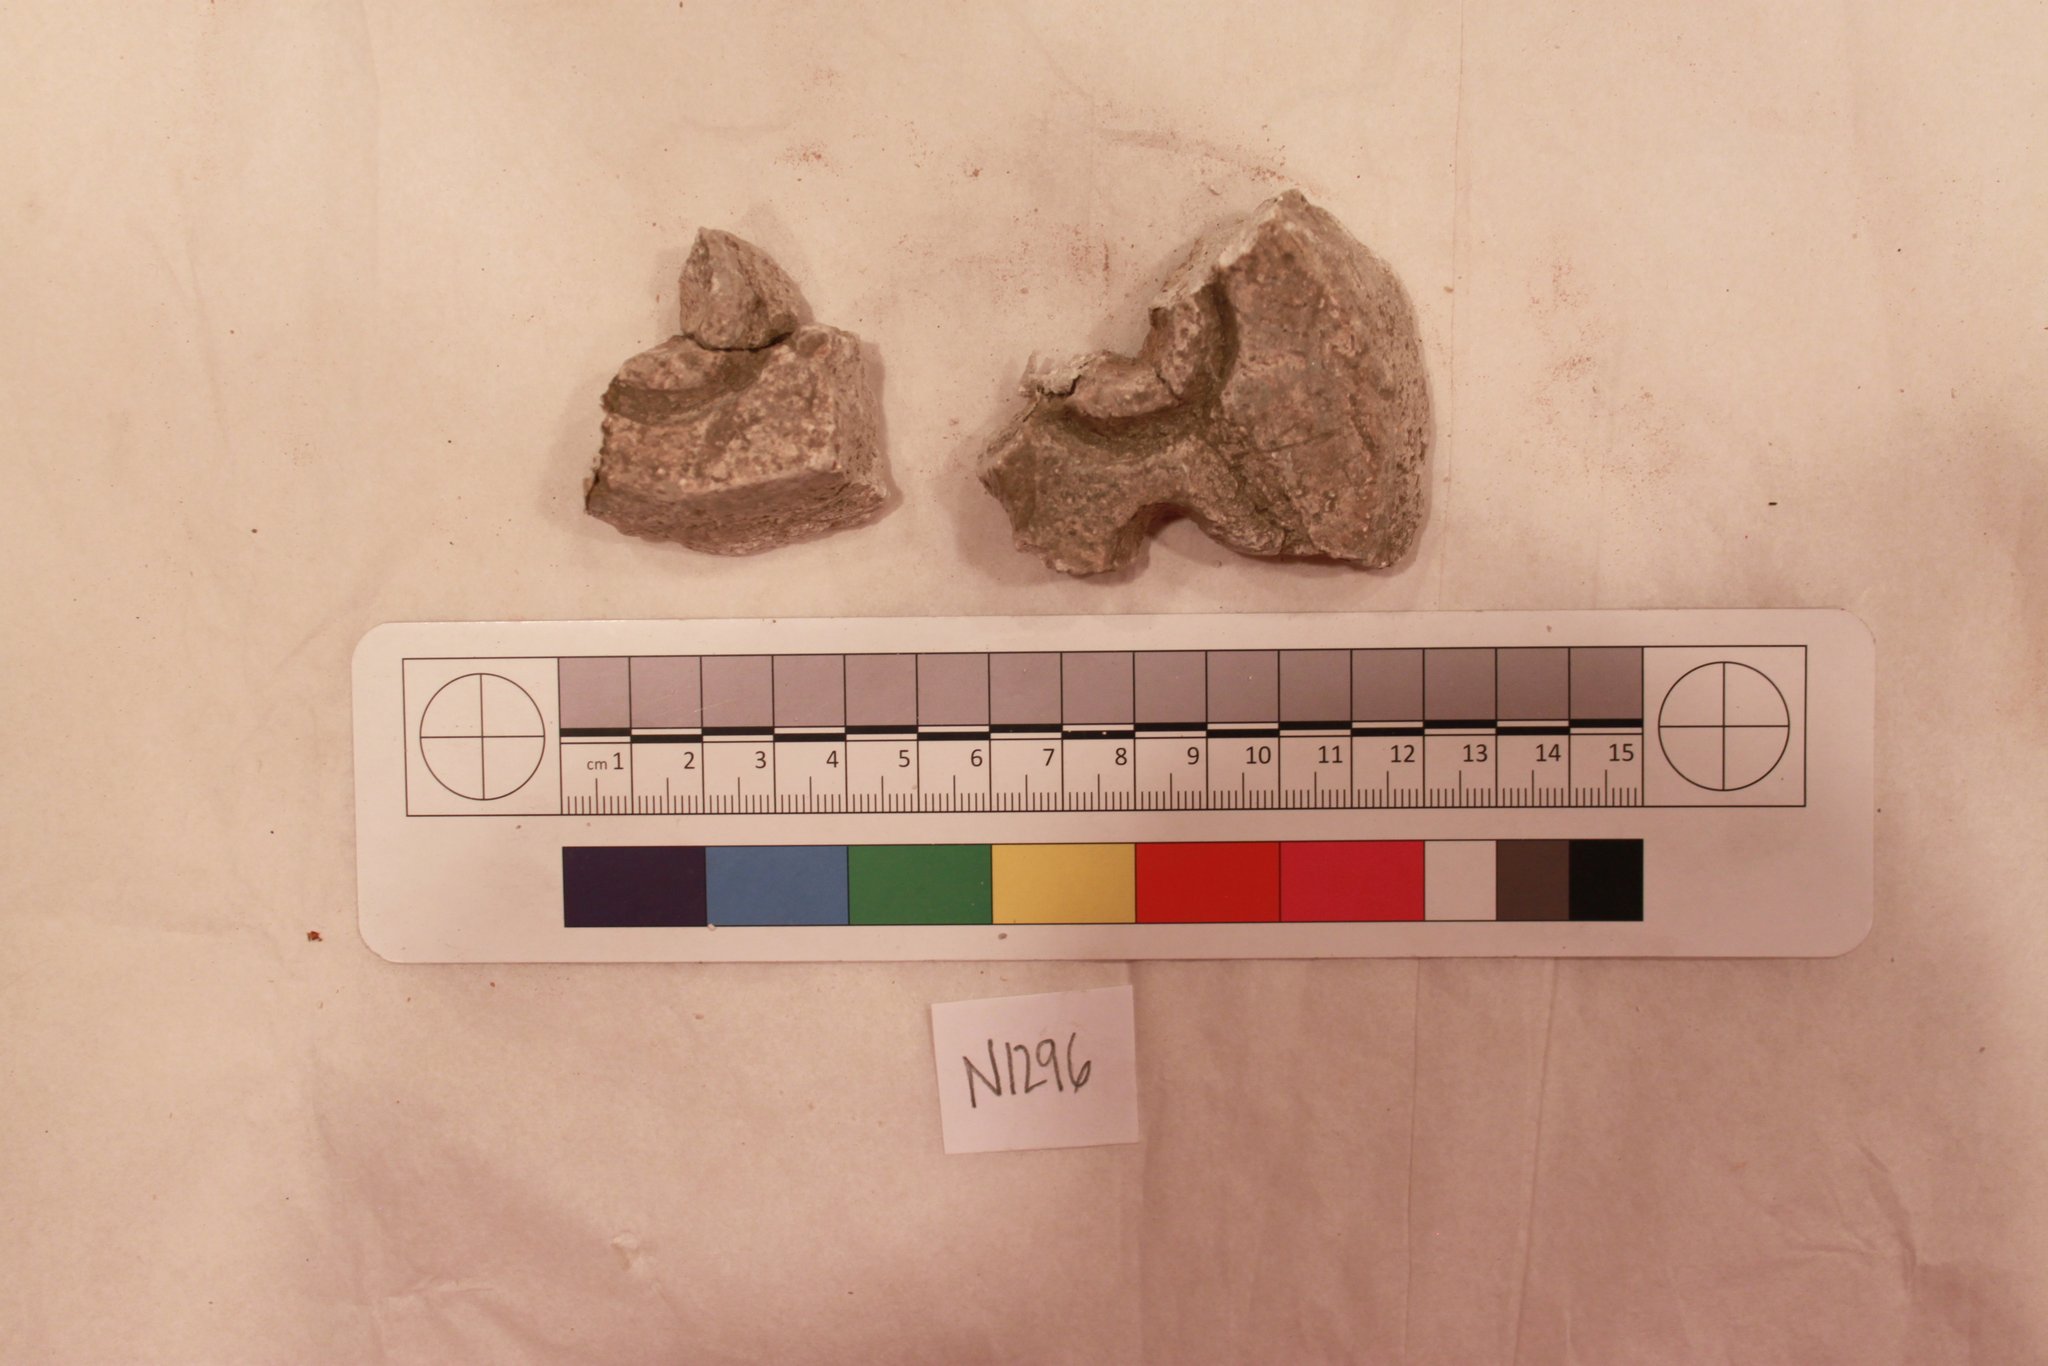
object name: fragment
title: Stucco Fragment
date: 701-1200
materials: plaster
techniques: carving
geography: iran